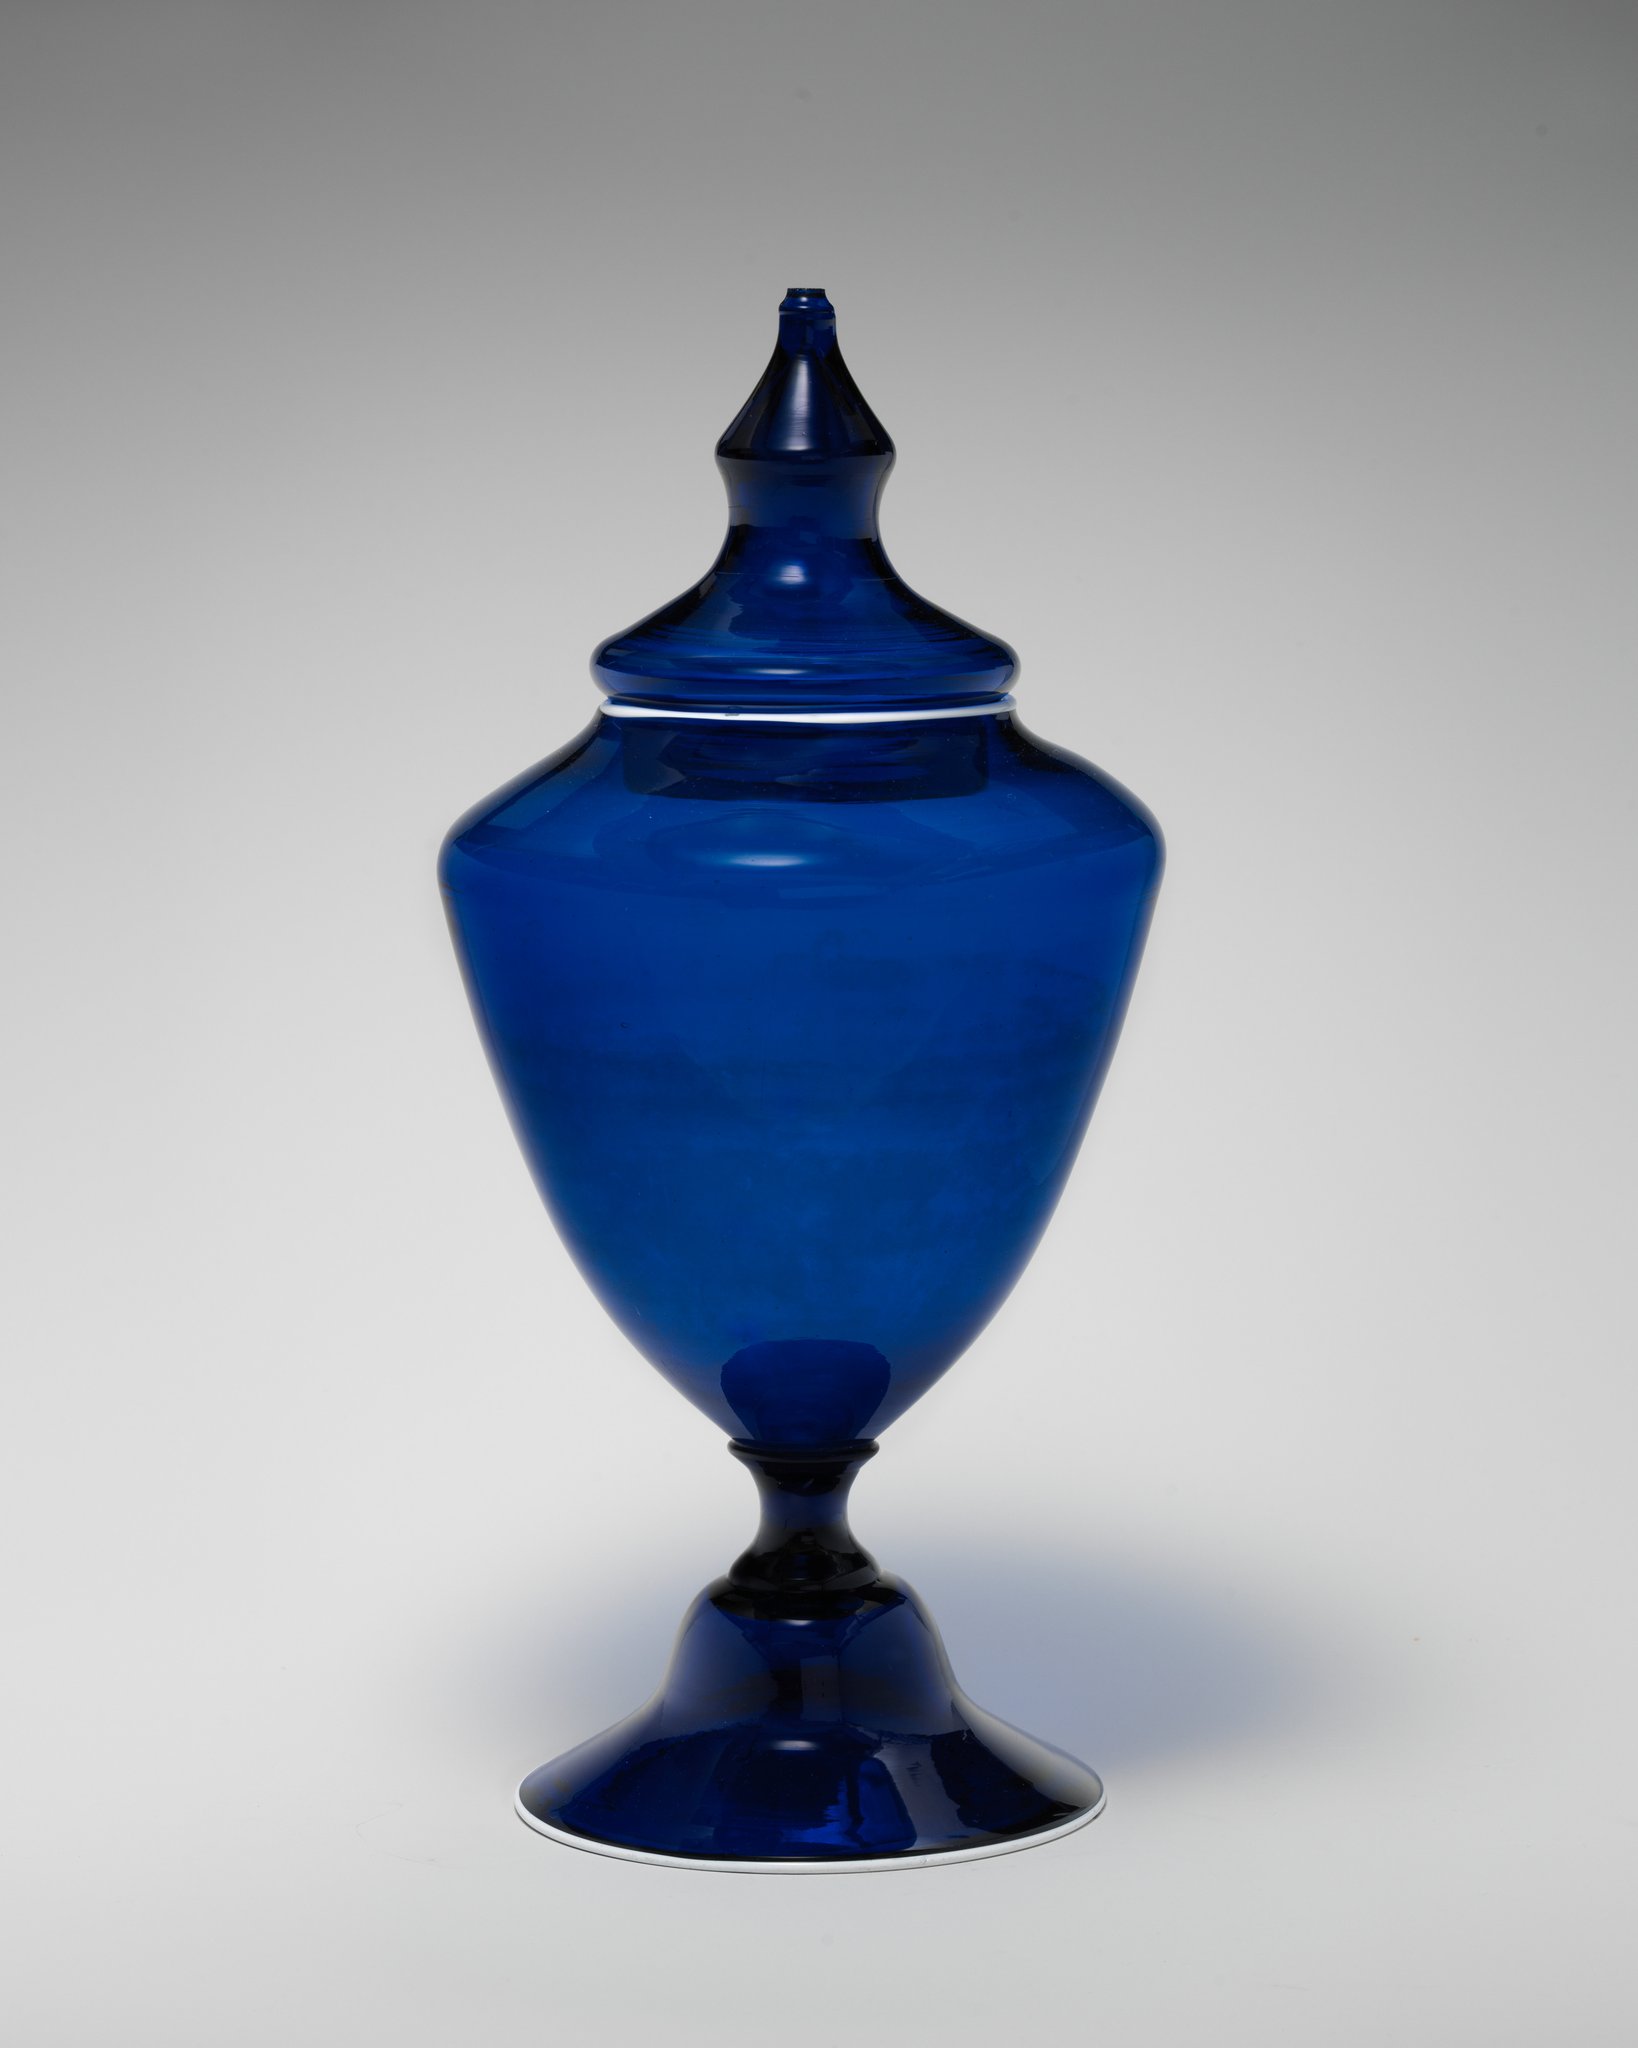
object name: jar with cover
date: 1767-1800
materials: glass